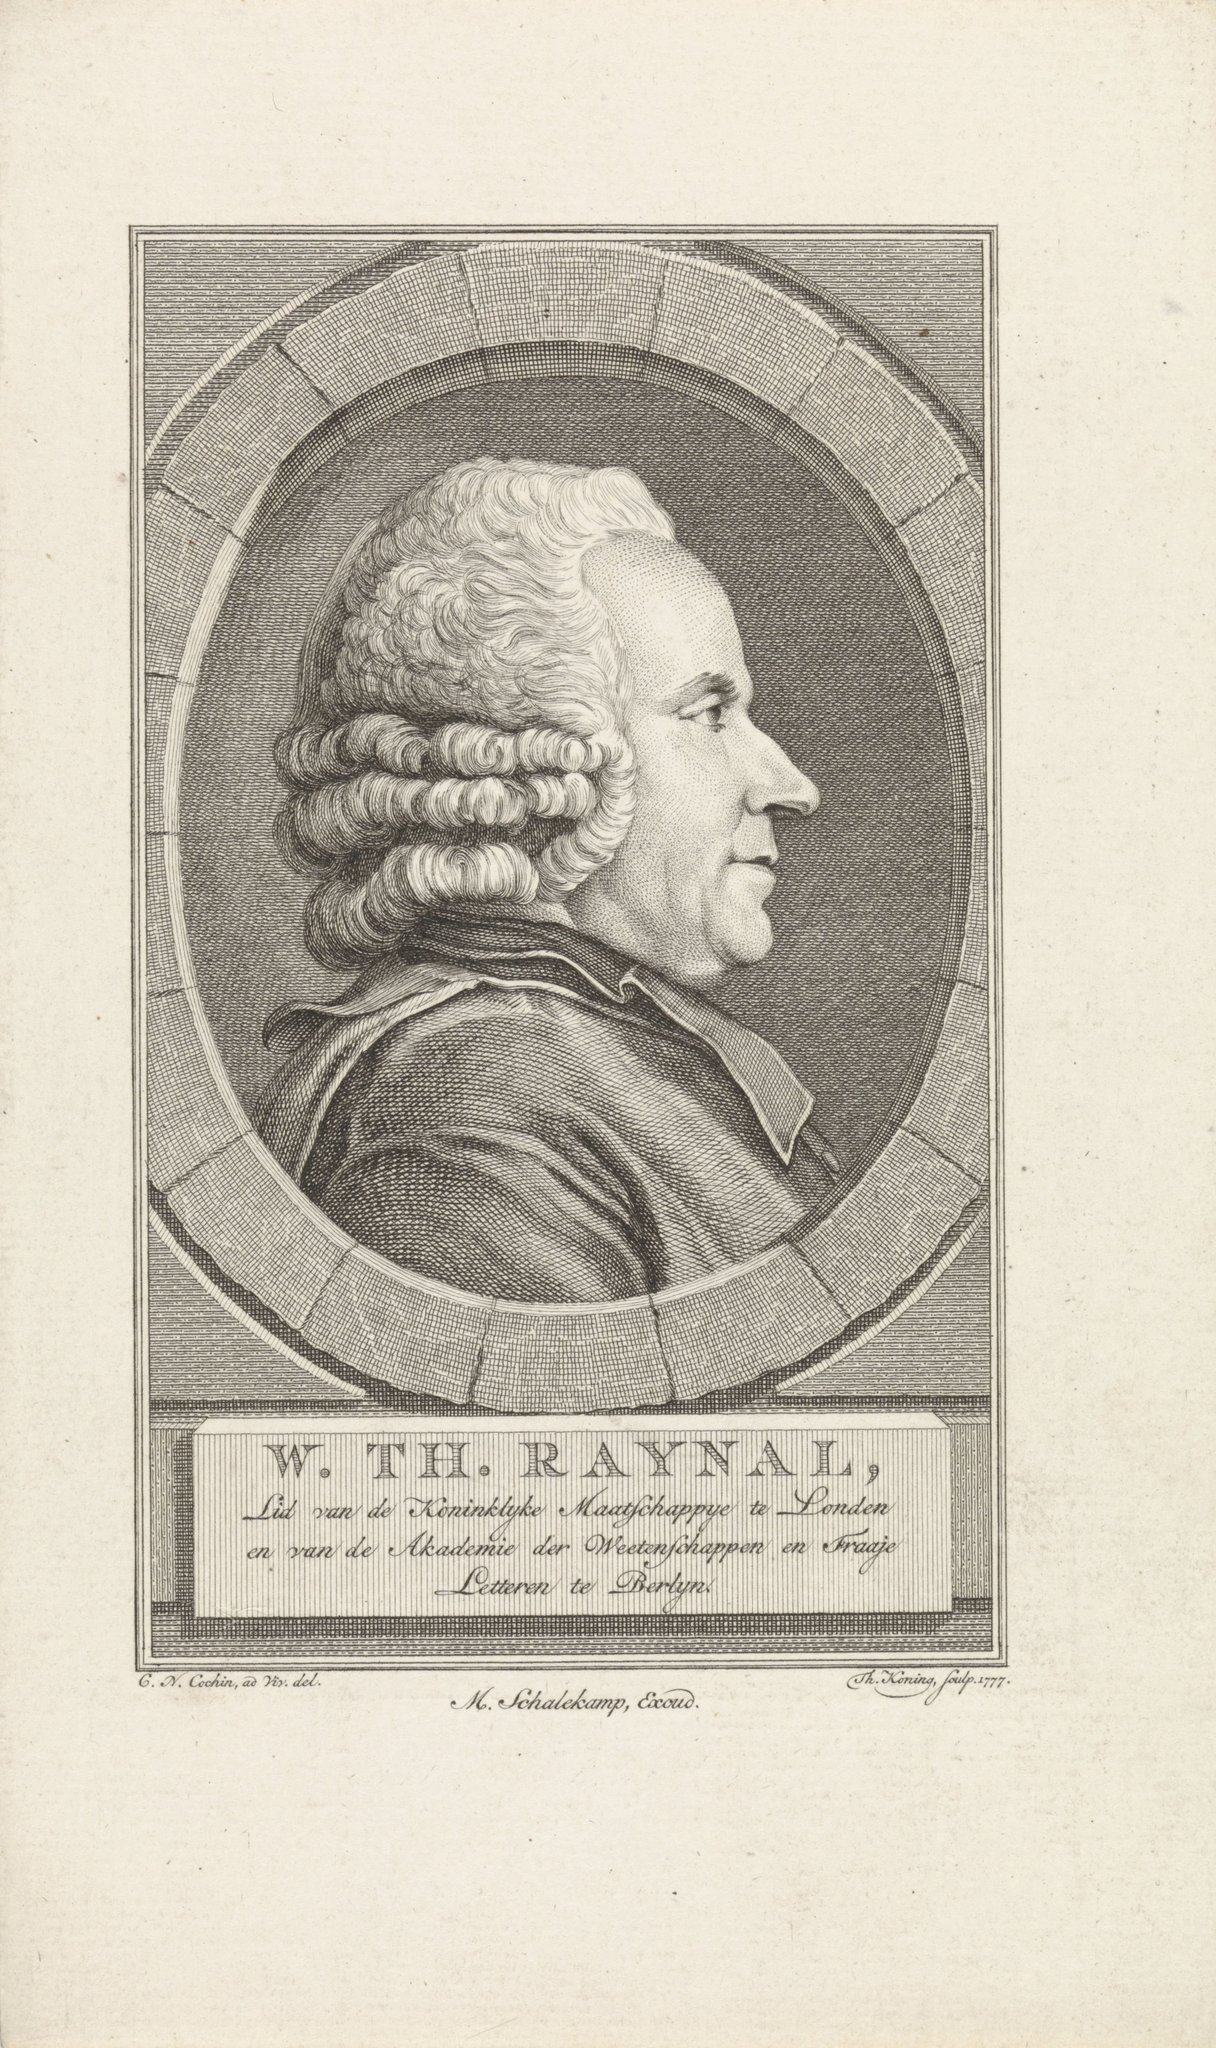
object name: print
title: Portret van Guillaume-Thomas François Raynal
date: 1777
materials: paper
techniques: engraving, etching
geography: amsterdam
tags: paris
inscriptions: collector's mark: Lugt 2228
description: Portretbuste van de Franse schrijver Guillaume-Thomas François Raynal. Onder het portret een plaquette met een vierregelige tekst.